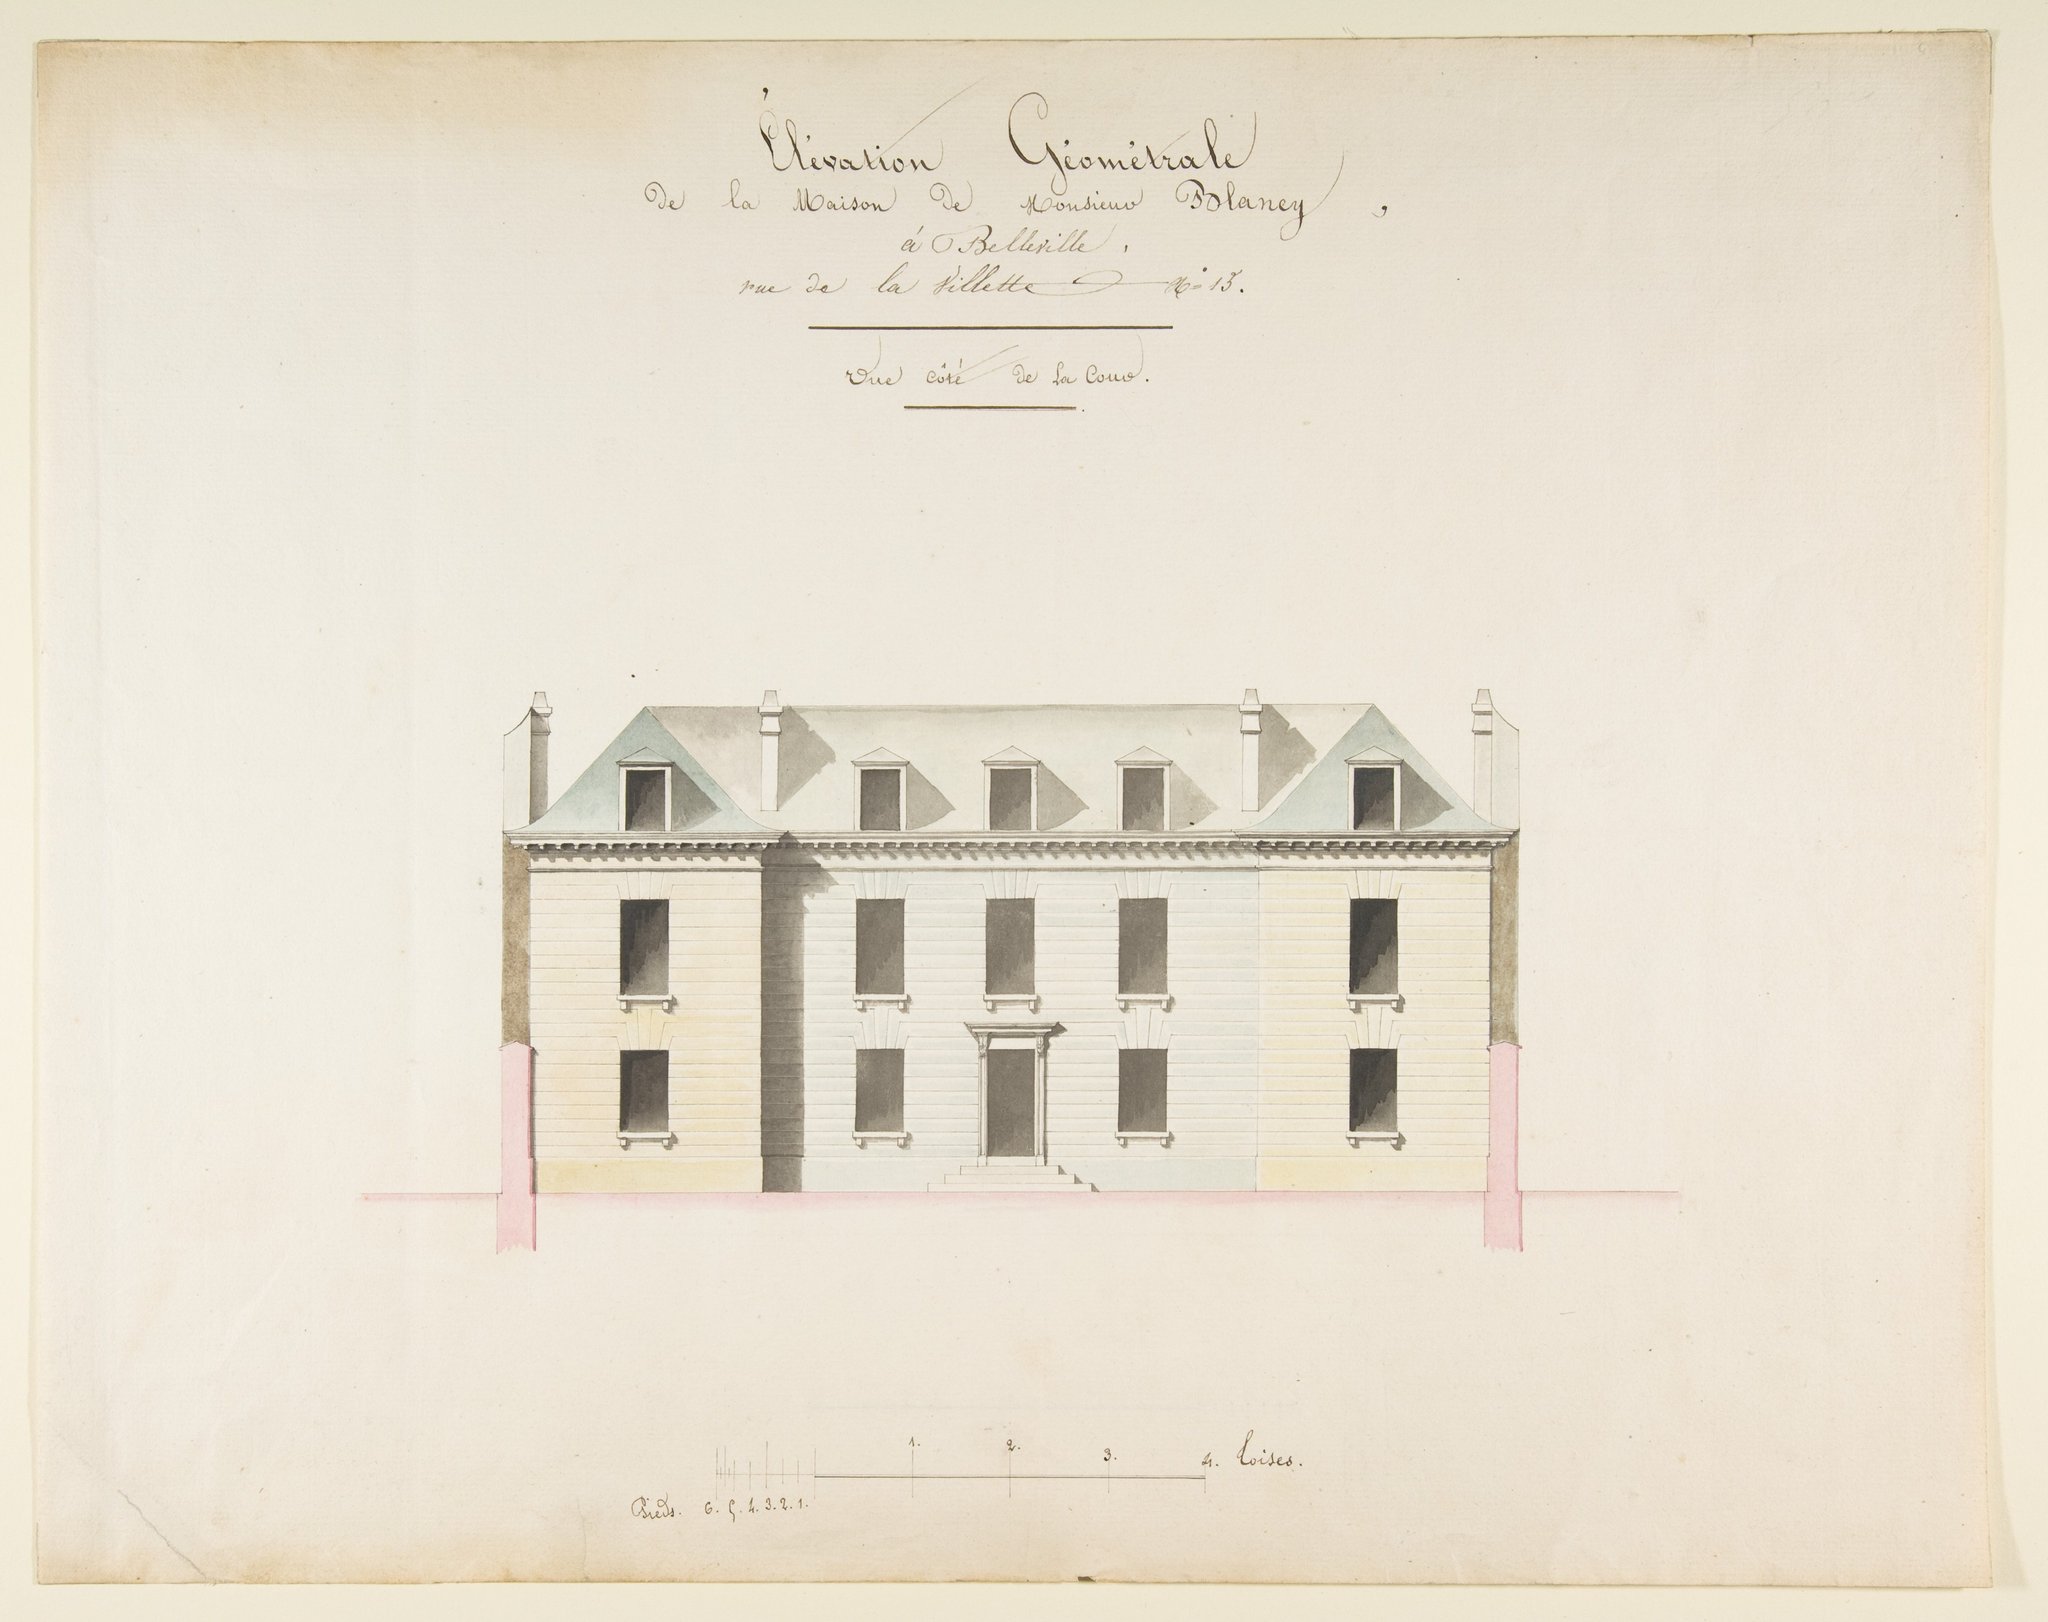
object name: drawing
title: Design for the Exterior Façade of the Country House of Monsieur Blaney, Belleville (recto); Design for façade (verso)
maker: anonymous, french, 18th century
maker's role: artist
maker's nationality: french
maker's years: 1700-1800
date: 1701-1800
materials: ink, watercolor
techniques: pen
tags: architecture,houses